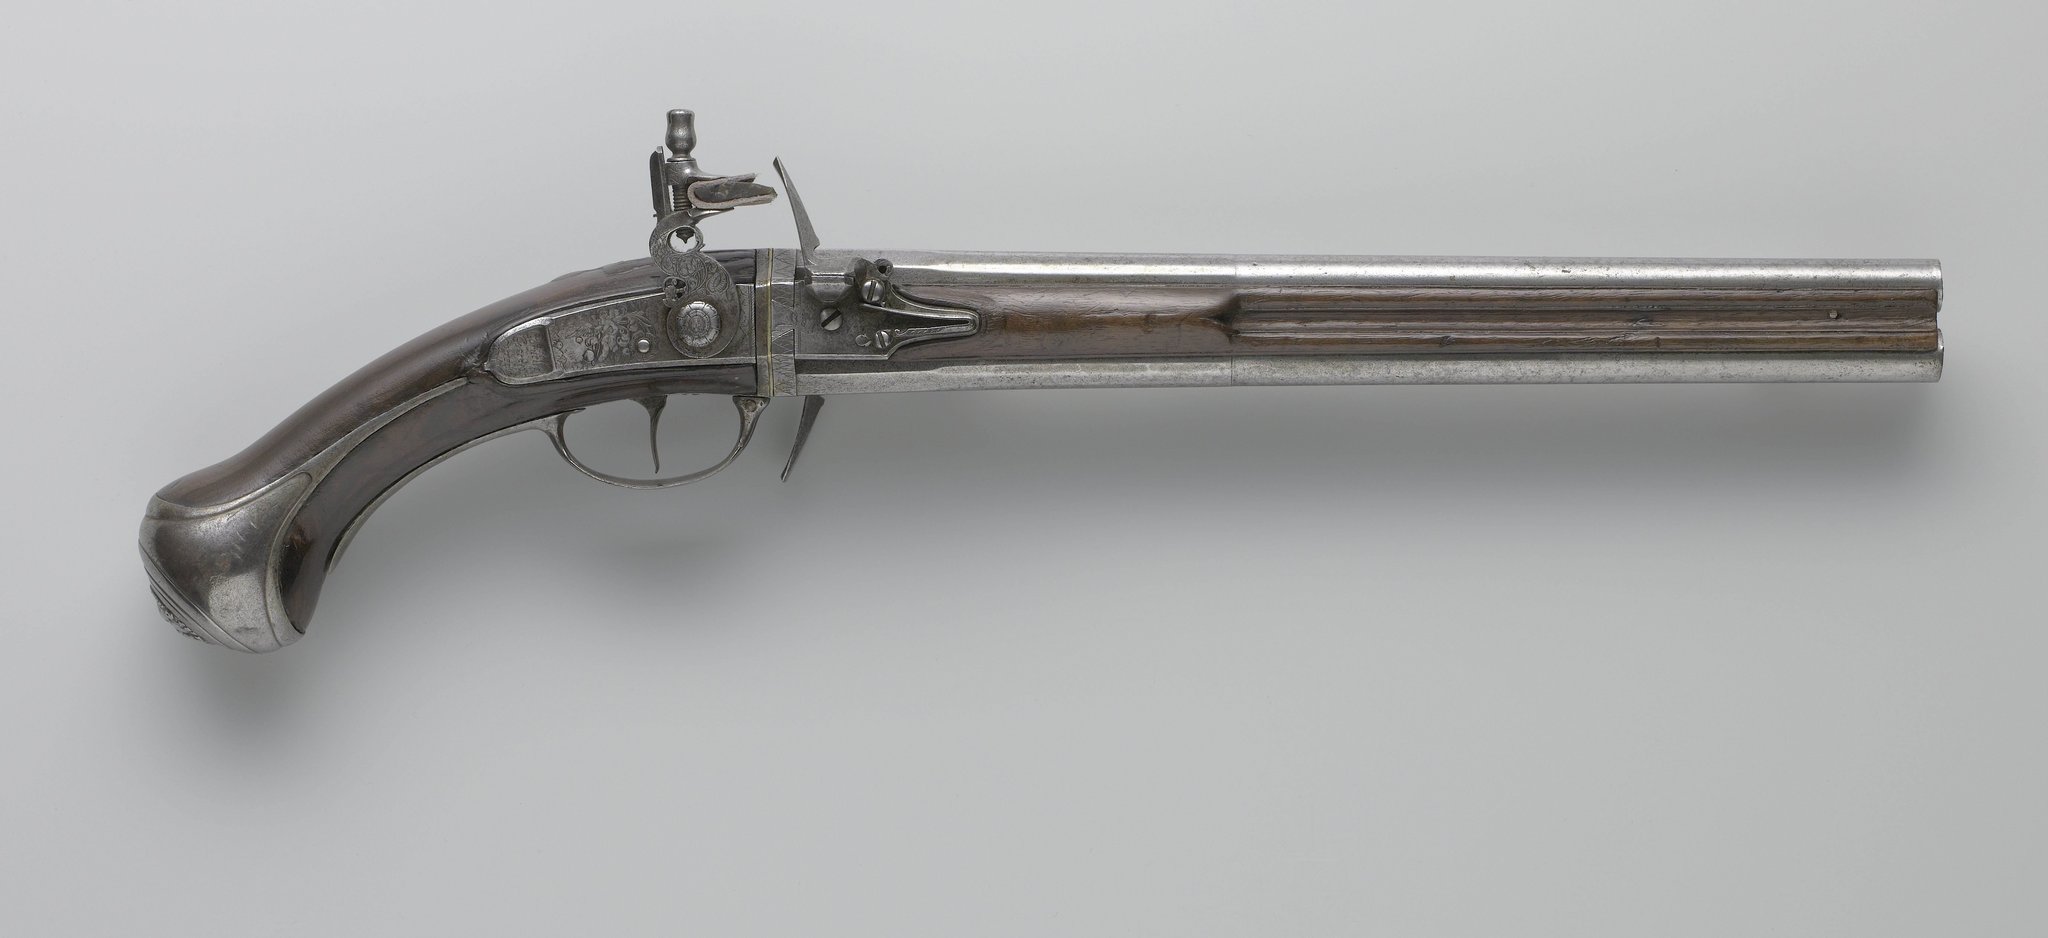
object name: superposee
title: Dubbelloops vuursteendraailooppistool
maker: cornelis coster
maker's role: geweermaker, pistoolmaker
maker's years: -1698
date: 1655-1660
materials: iron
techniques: cutting, engraving, pierced, striking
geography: utrecht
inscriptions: signature: ‘Cornelis // Coster // vtrecht’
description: Het slot is voorzien van bloemen- en bladerranken met een masker en een putto, gedeeltelijk in bas-reliëf, gedeeltelijk gegrafeerd en draagt een signatuur. De twee lopen zijn boven elkaar gemonteerd. De kolf heeft aan beide zijden een groef met daarin aan een kant plaats voor de laadstok. Het ijzeren beslag bestaat onder meer uit een ajour bewerkte, gekrulde schroefplaat en de kolfkap met dekplaat met een gebeiteld masker.